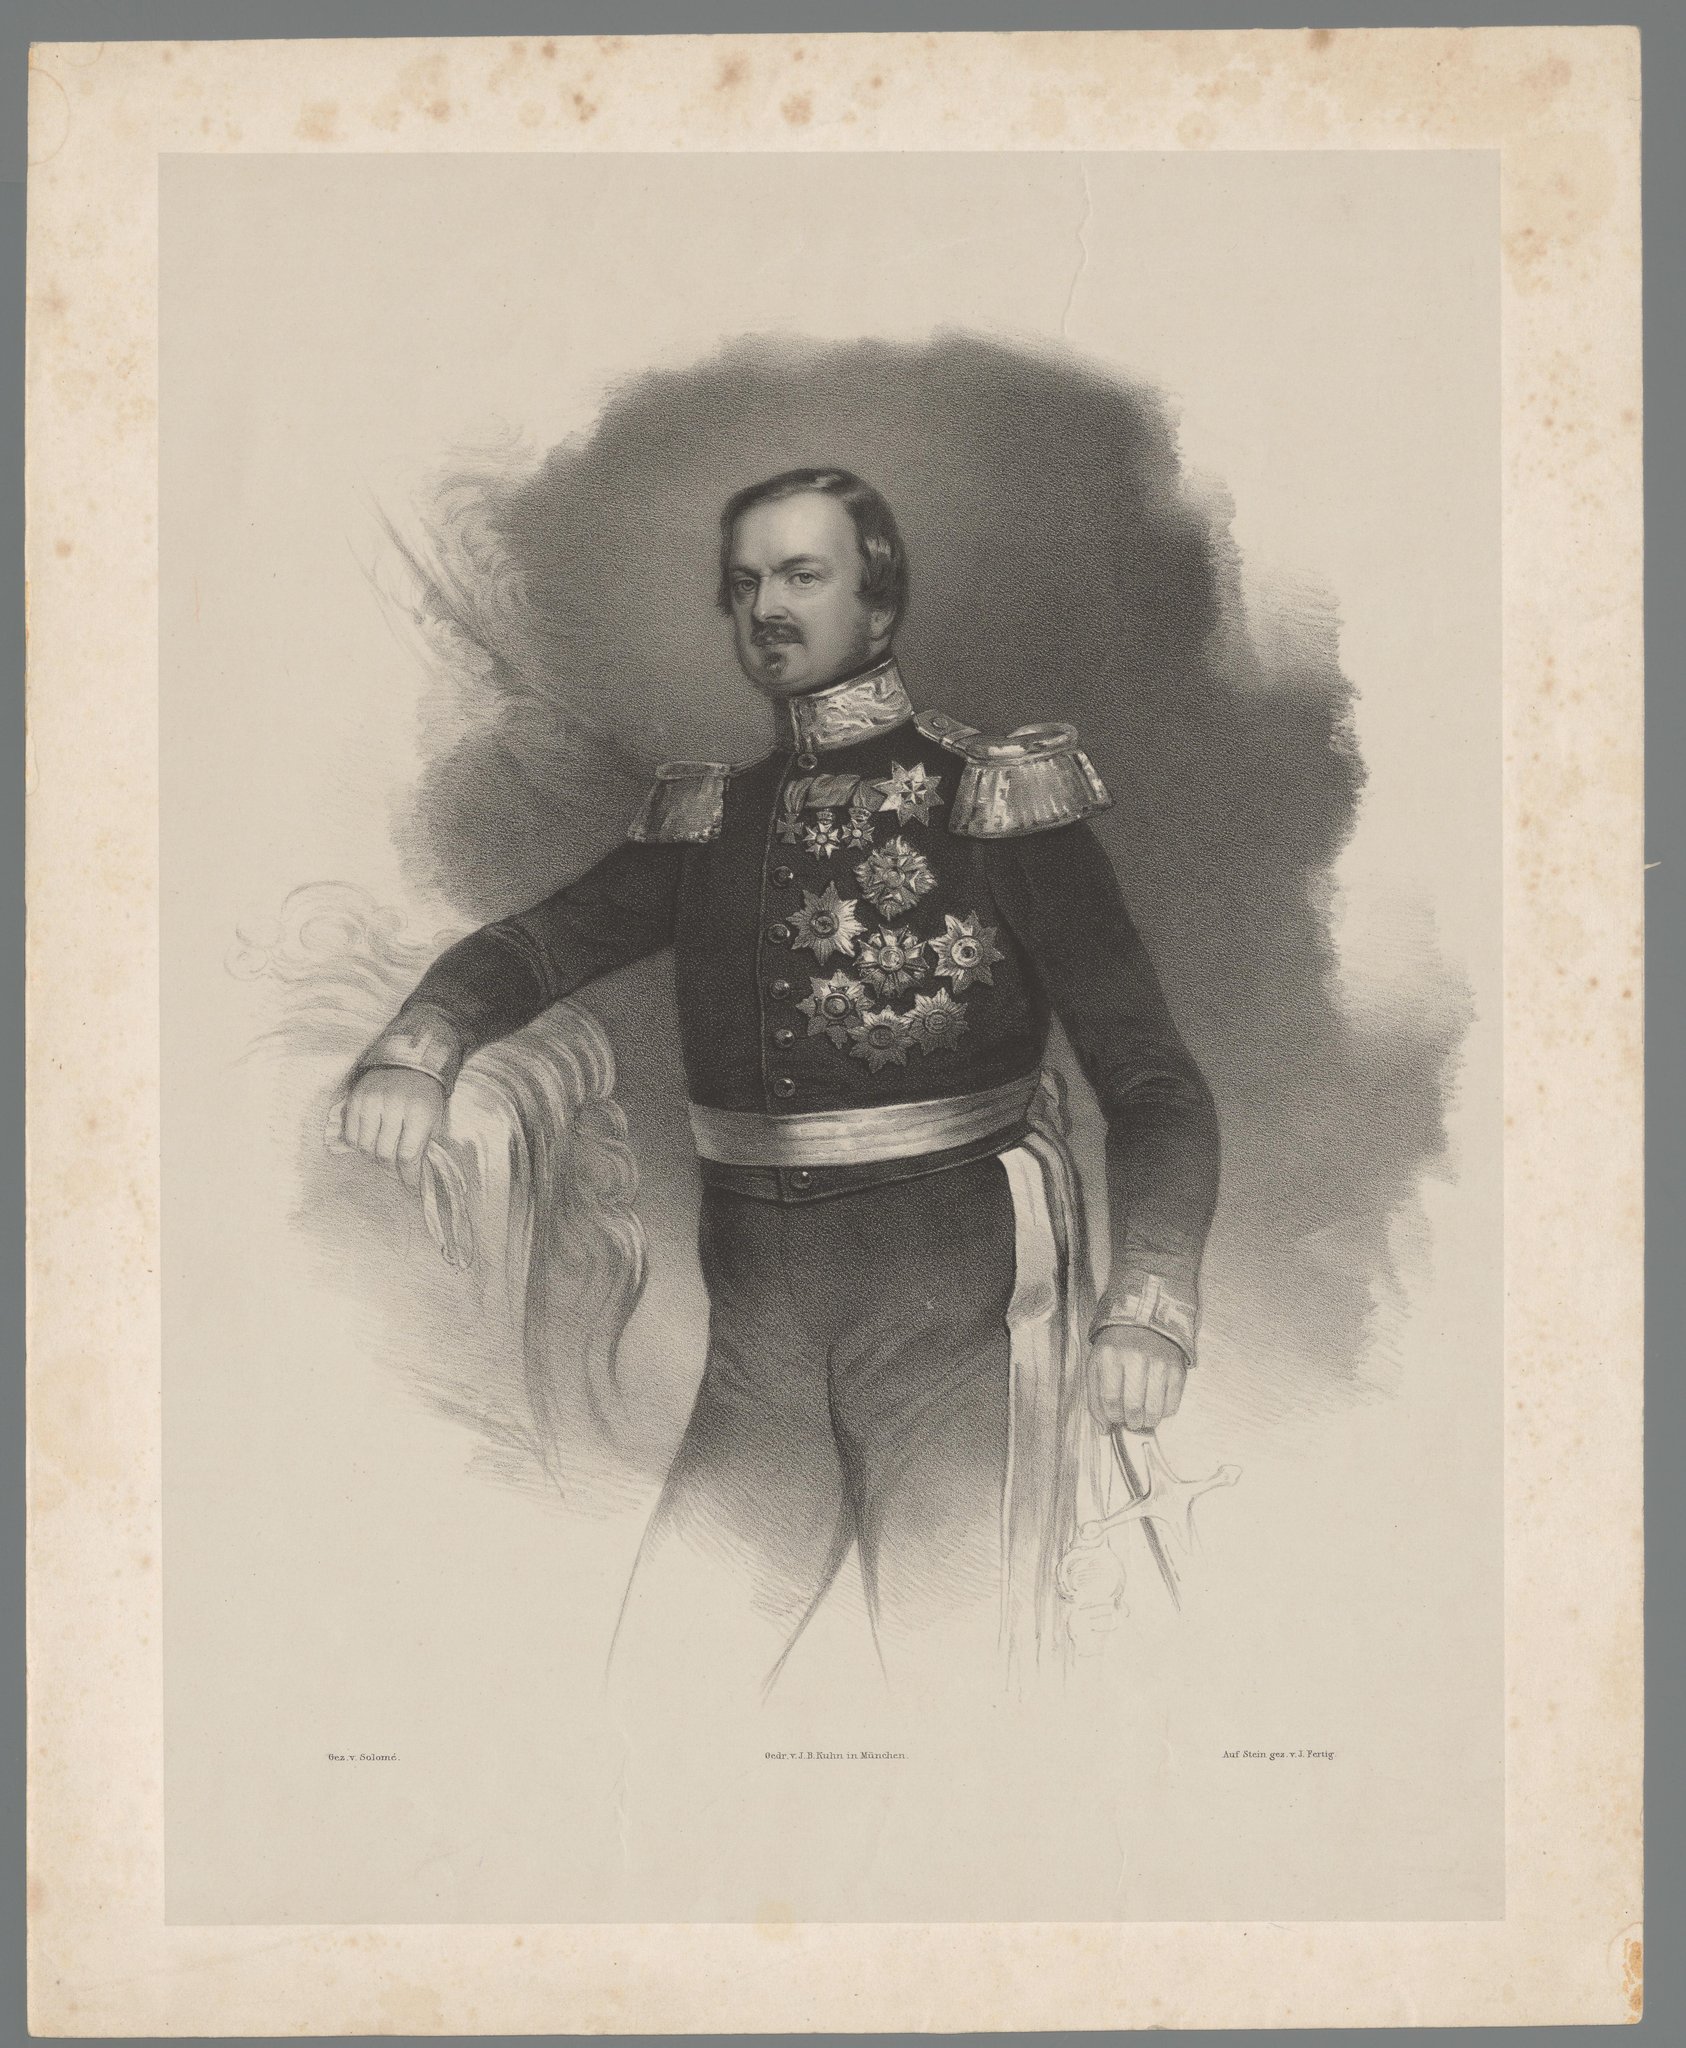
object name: print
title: Portret van een onbekende man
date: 1830-1858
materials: paper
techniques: lithograph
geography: munich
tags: ranks in the army, historical persons not known by name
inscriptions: collector's mark: Lugt 2228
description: Portret van een verder onbekende militair.